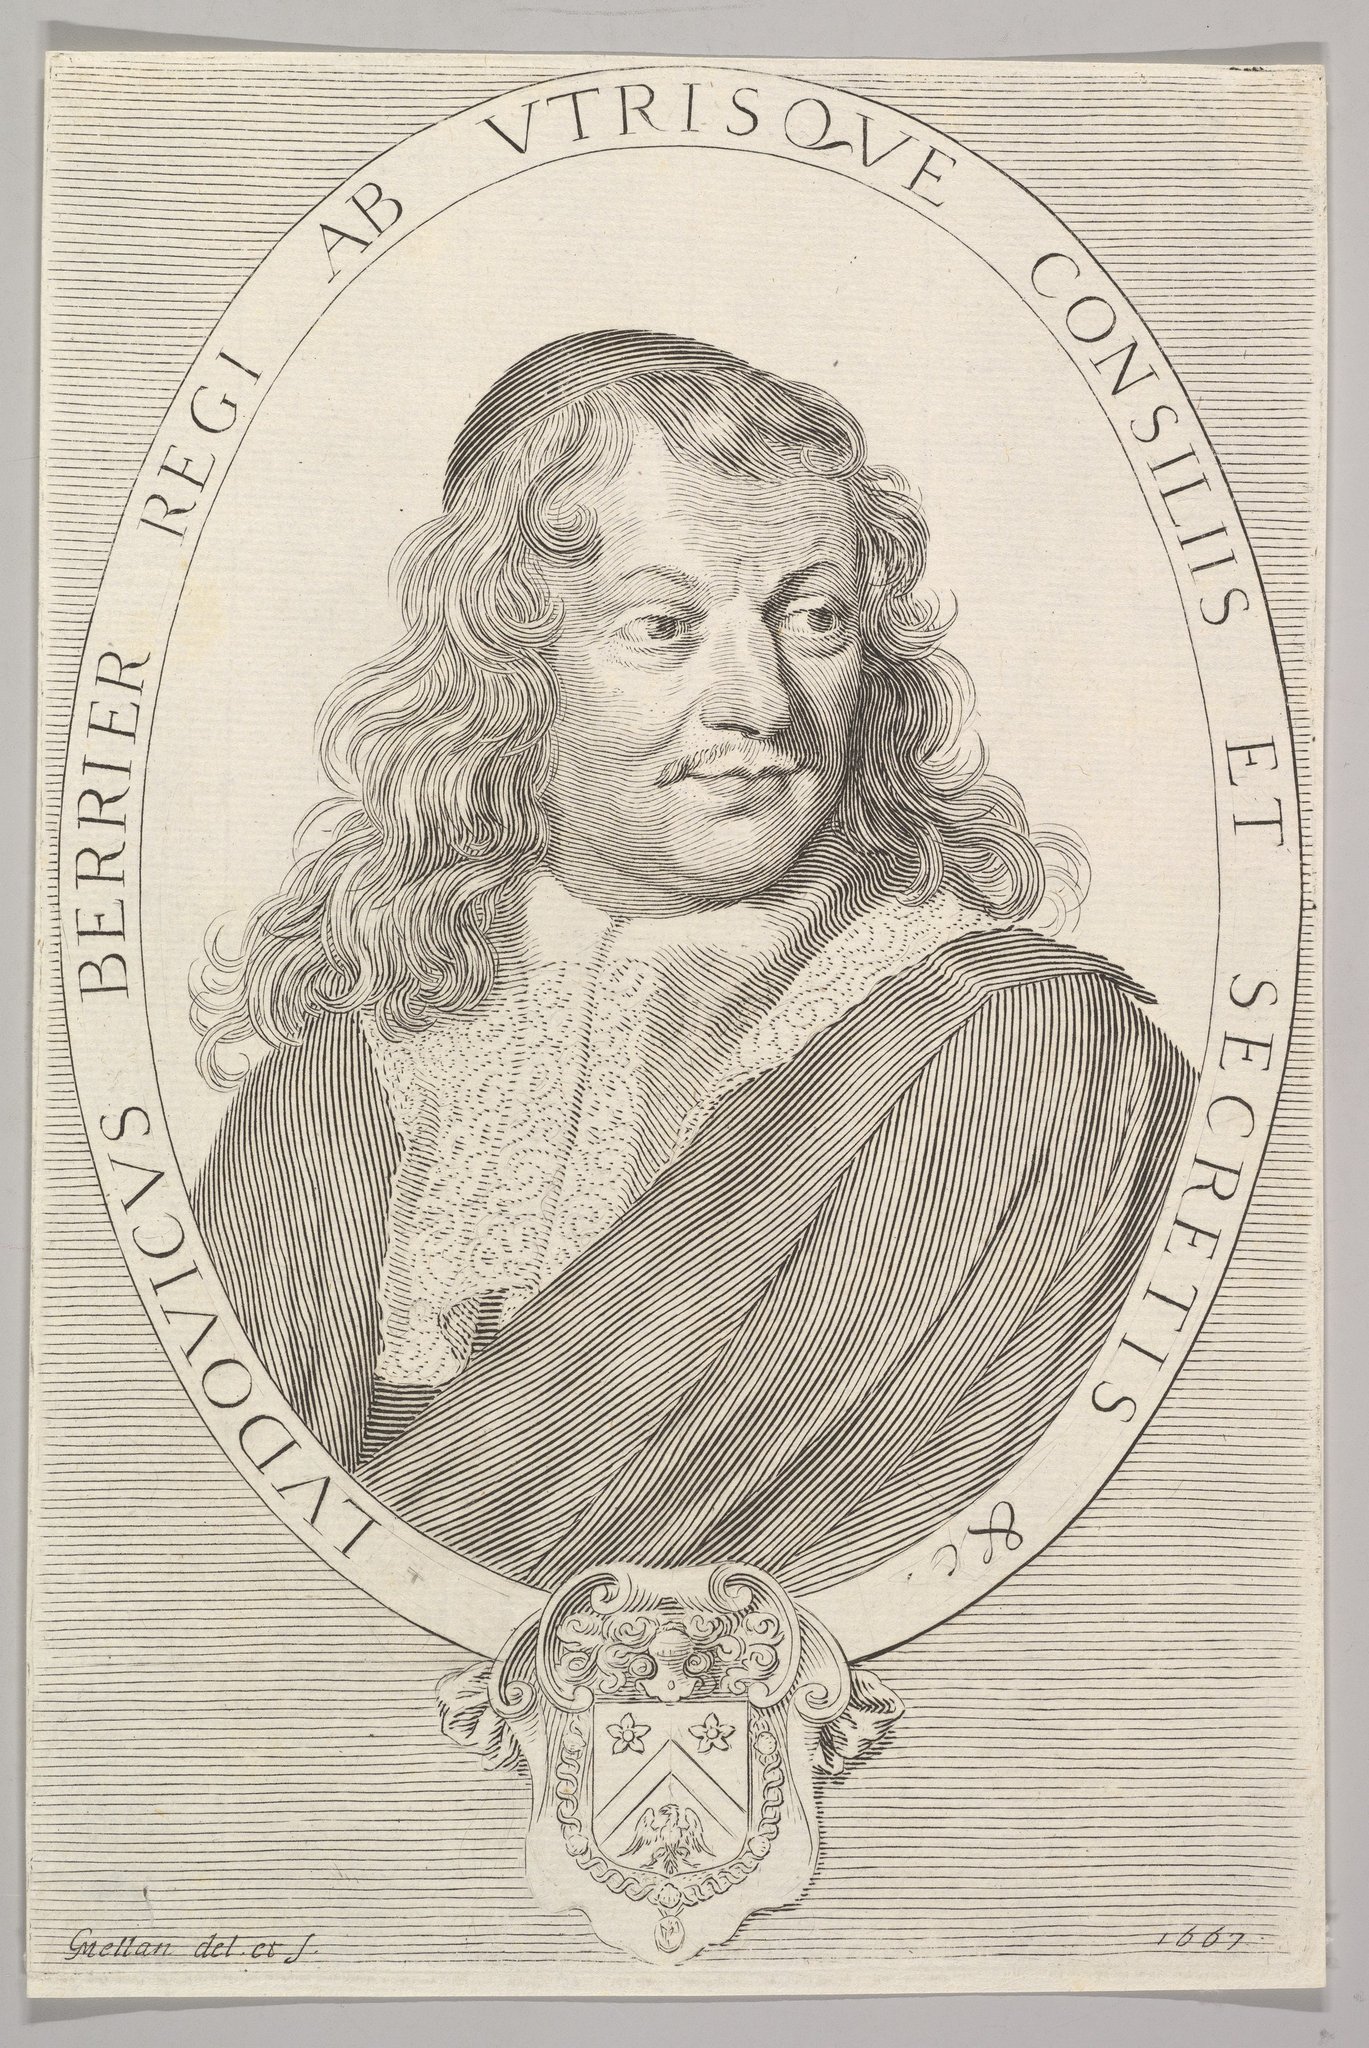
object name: print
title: Louis Berryer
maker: claude mellan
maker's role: artist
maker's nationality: french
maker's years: 1598-1688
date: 1667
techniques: engraving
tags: men,portraits